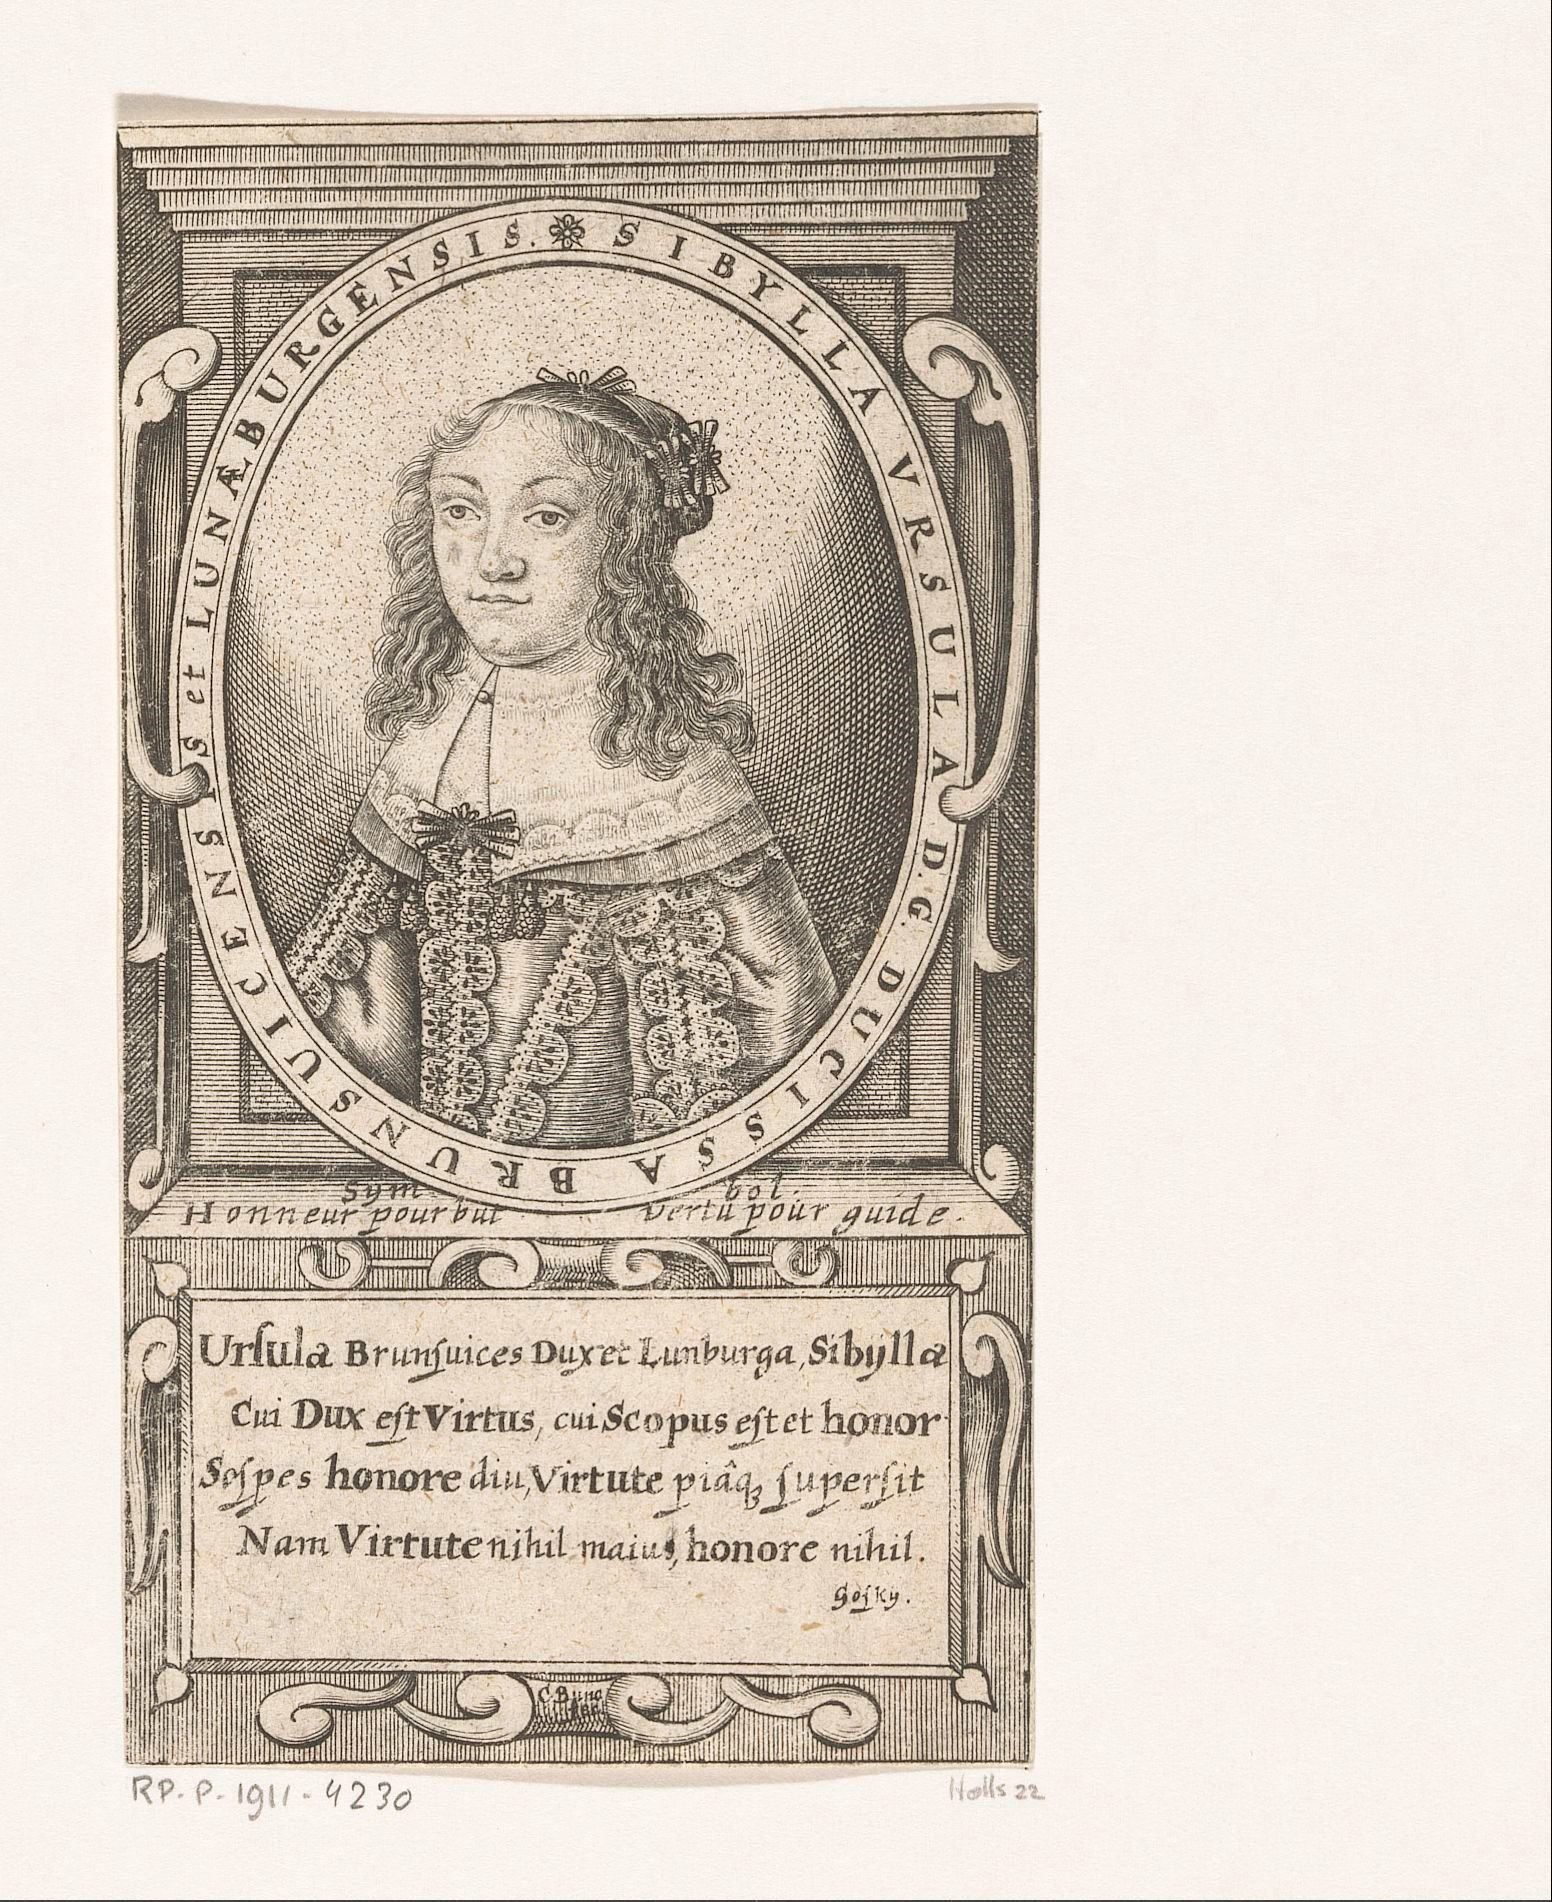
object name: book illustration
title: Portret van Sibylla Ursula von Braunschweig-Wolfenbüttel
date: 1649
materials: paper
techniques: engraving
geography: ulm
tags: historical persons - bb - woman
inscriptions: collector's mark: Lugt 2228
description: Prent afkomstig uit: Andreä, Johann Valentin. Seleniana augustalia (...). Ulm: Balthasar Kuhn, [1649].